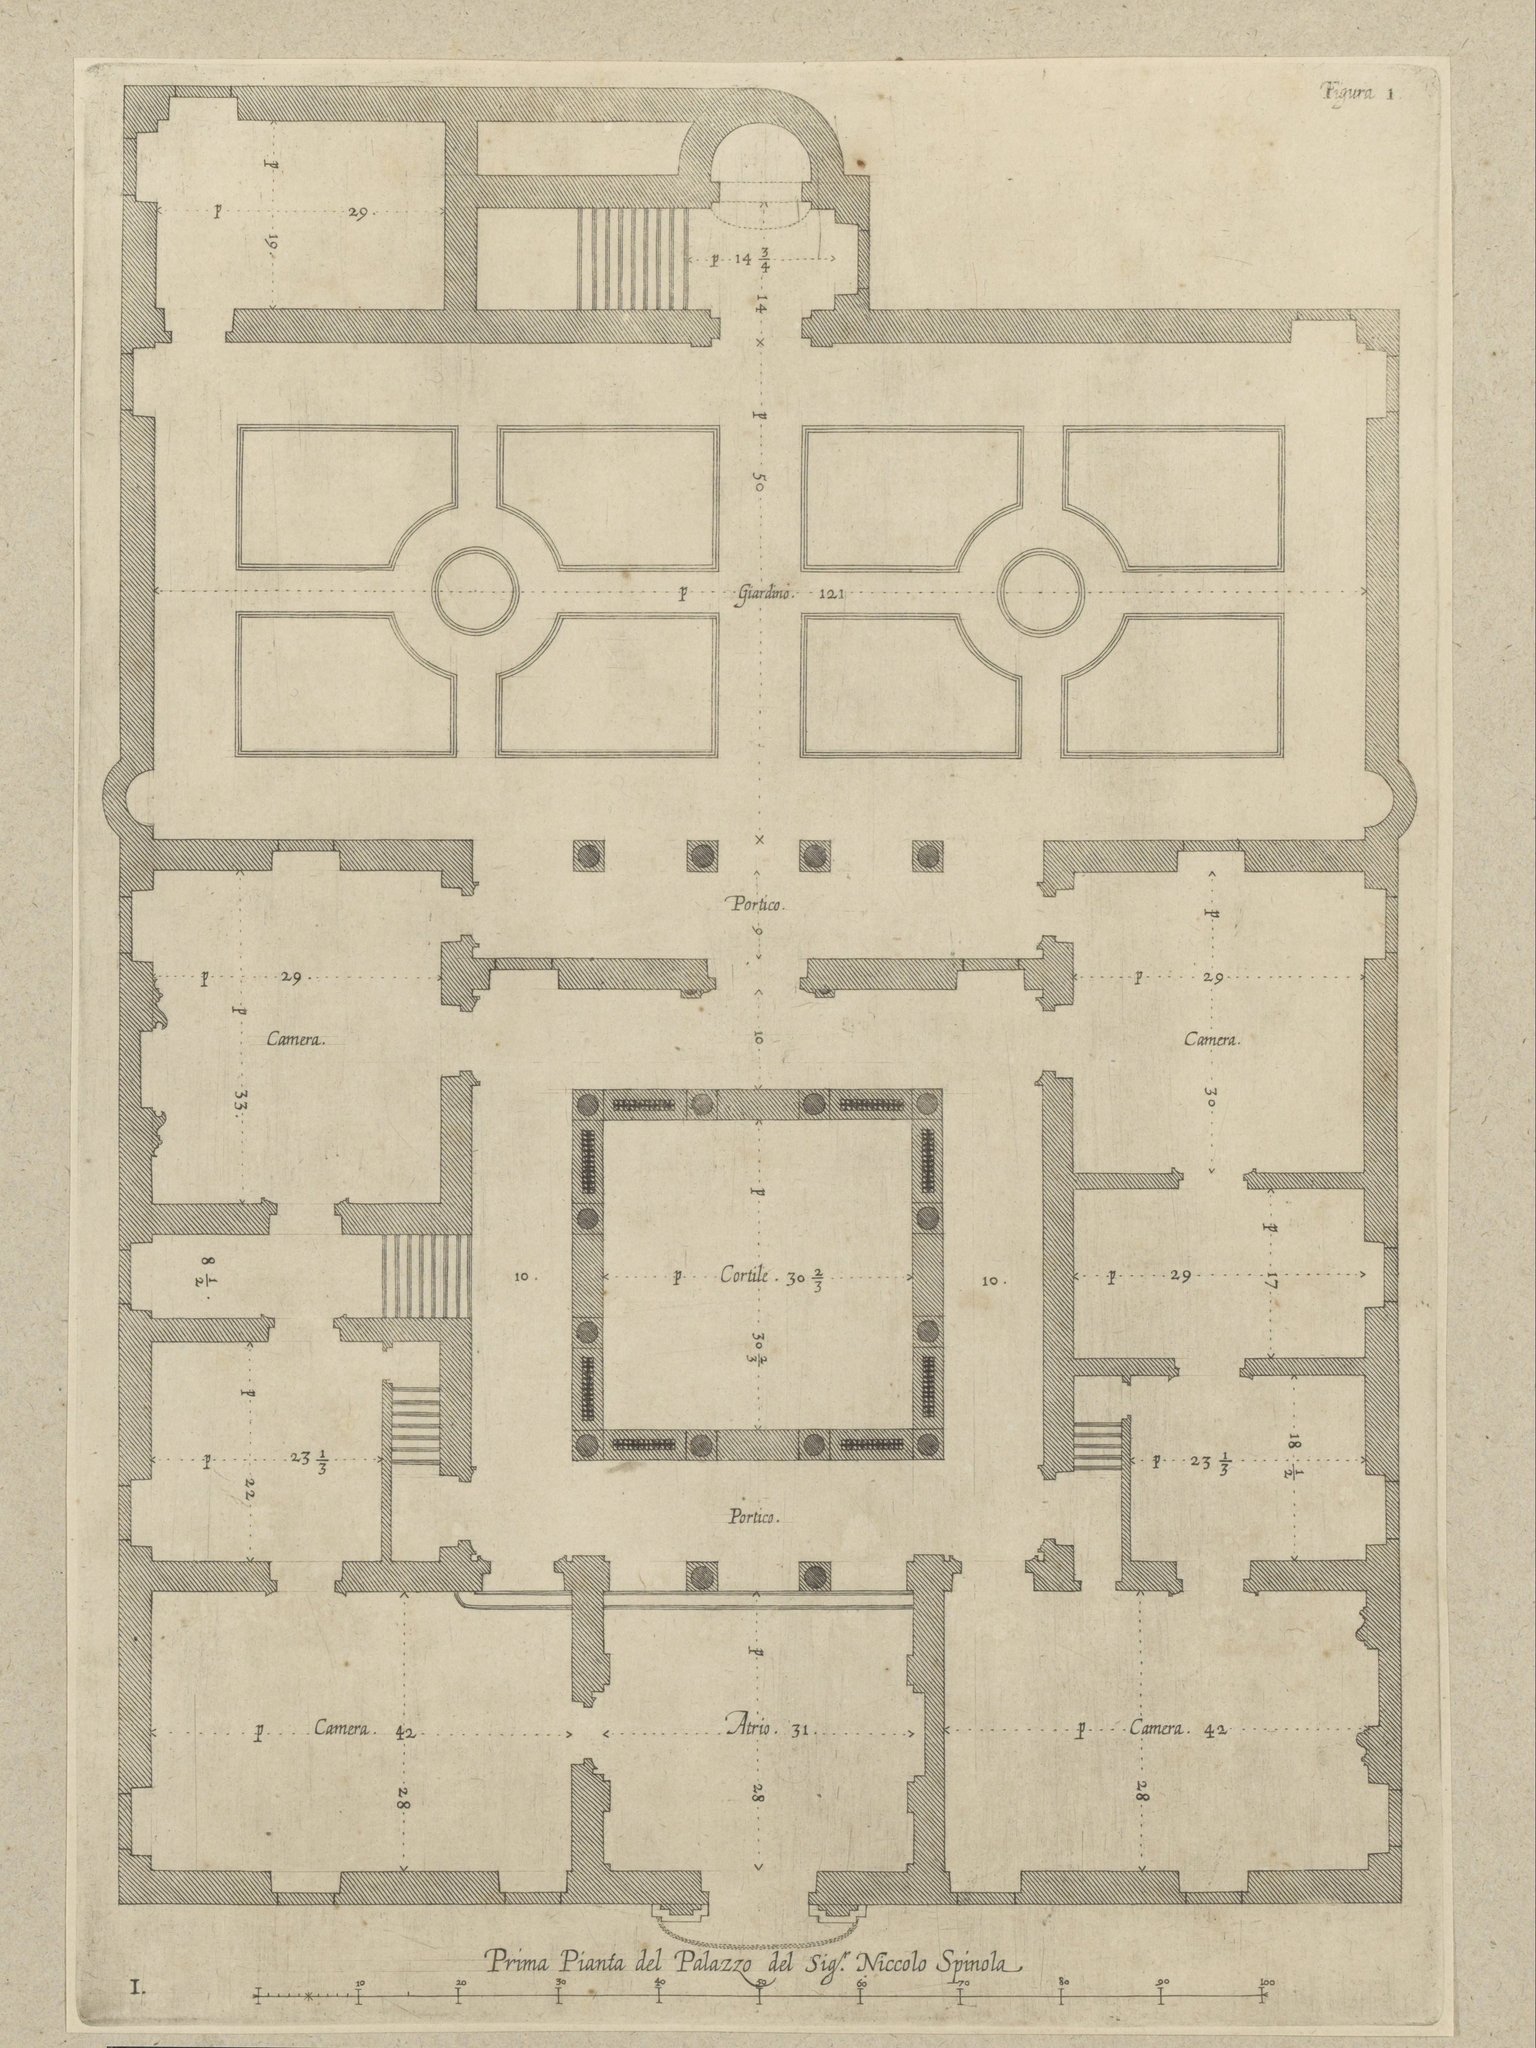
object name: print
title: Plattegrond van de begane grond van het Palazzo Doria te Genua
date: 1622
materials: paper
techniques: engraving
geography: antwerp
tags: hôtel, i.e. small palace in city - aa - civic architecture: inside, plan ~ architecture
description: Deze prent maakt deel uit van een album.